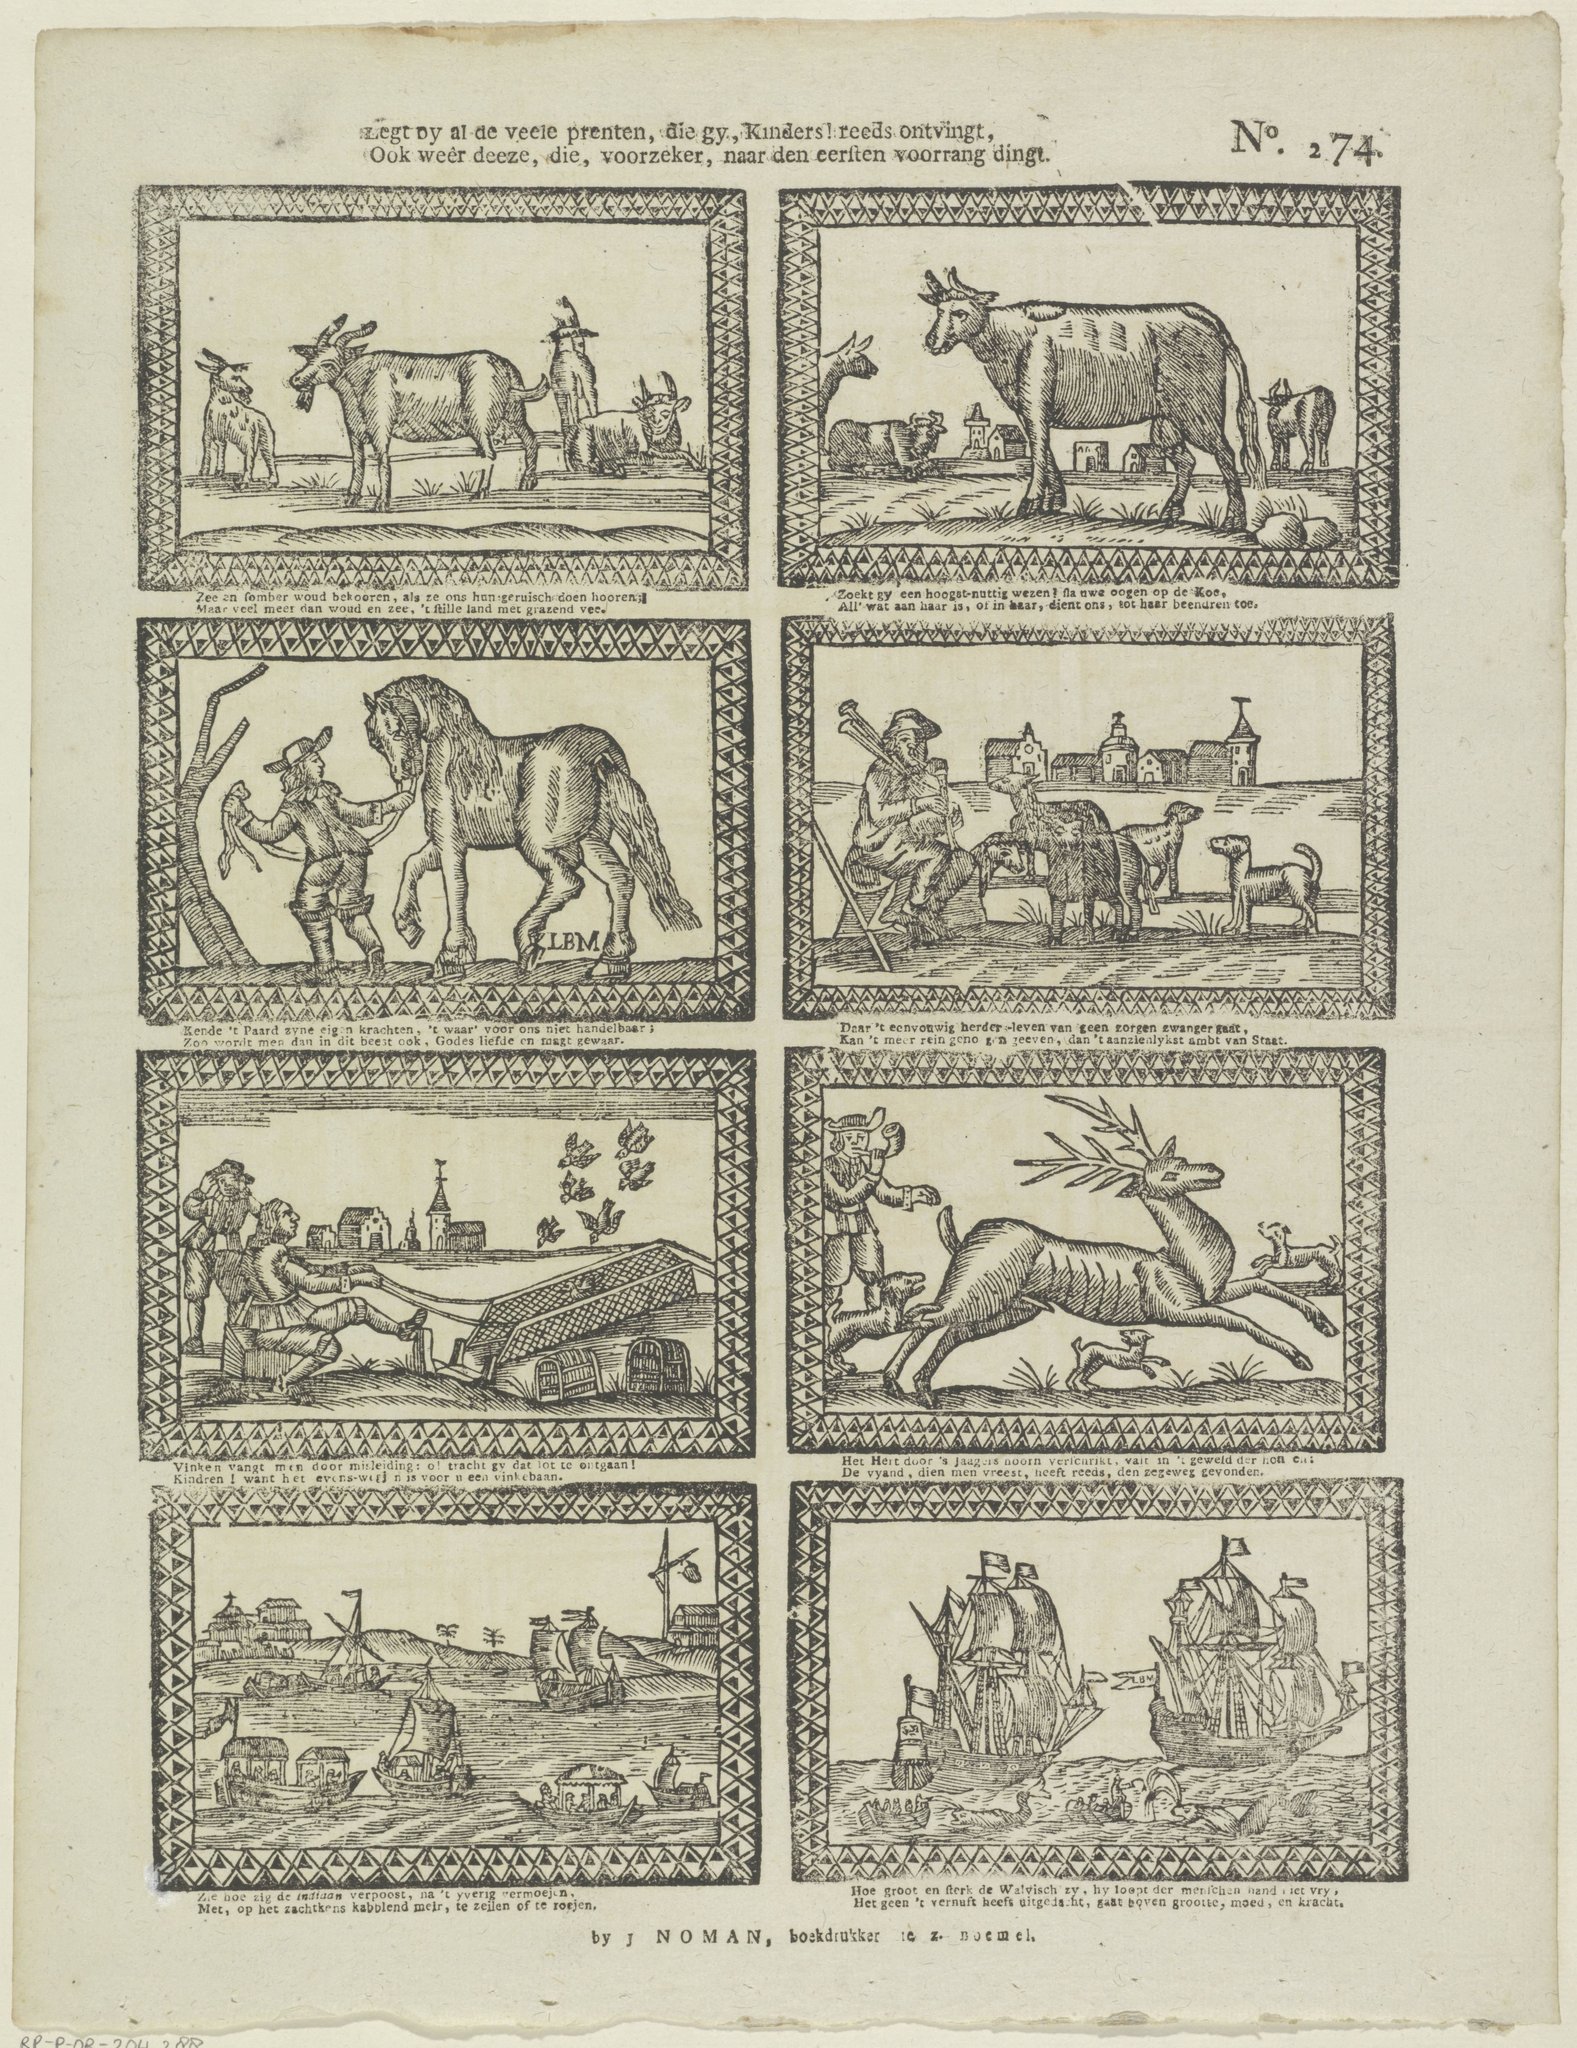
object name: popular print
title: Legt by al de veele prenten, die gy, kinders! reeds ontvingt, / Ook weêr deeze, die, voorzeker, naar den eersten voorrang dingt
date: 1806-1830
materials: paper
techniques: letterpress printing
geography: zaltbommel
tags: cow, herding, herdsman, herdswoman, shepherd, shepherdess, cowherd, etc., ships (in general), horse, goat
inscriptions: collector's mark: Lugt 2760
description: Blad met 8 voorstellingen van verschillende aard, waaronder voorstellingen van dieren, een herder en schepen. Onder elke afbeelding een tweeregelig vers. Genummerd rechtsboven: No. 274.